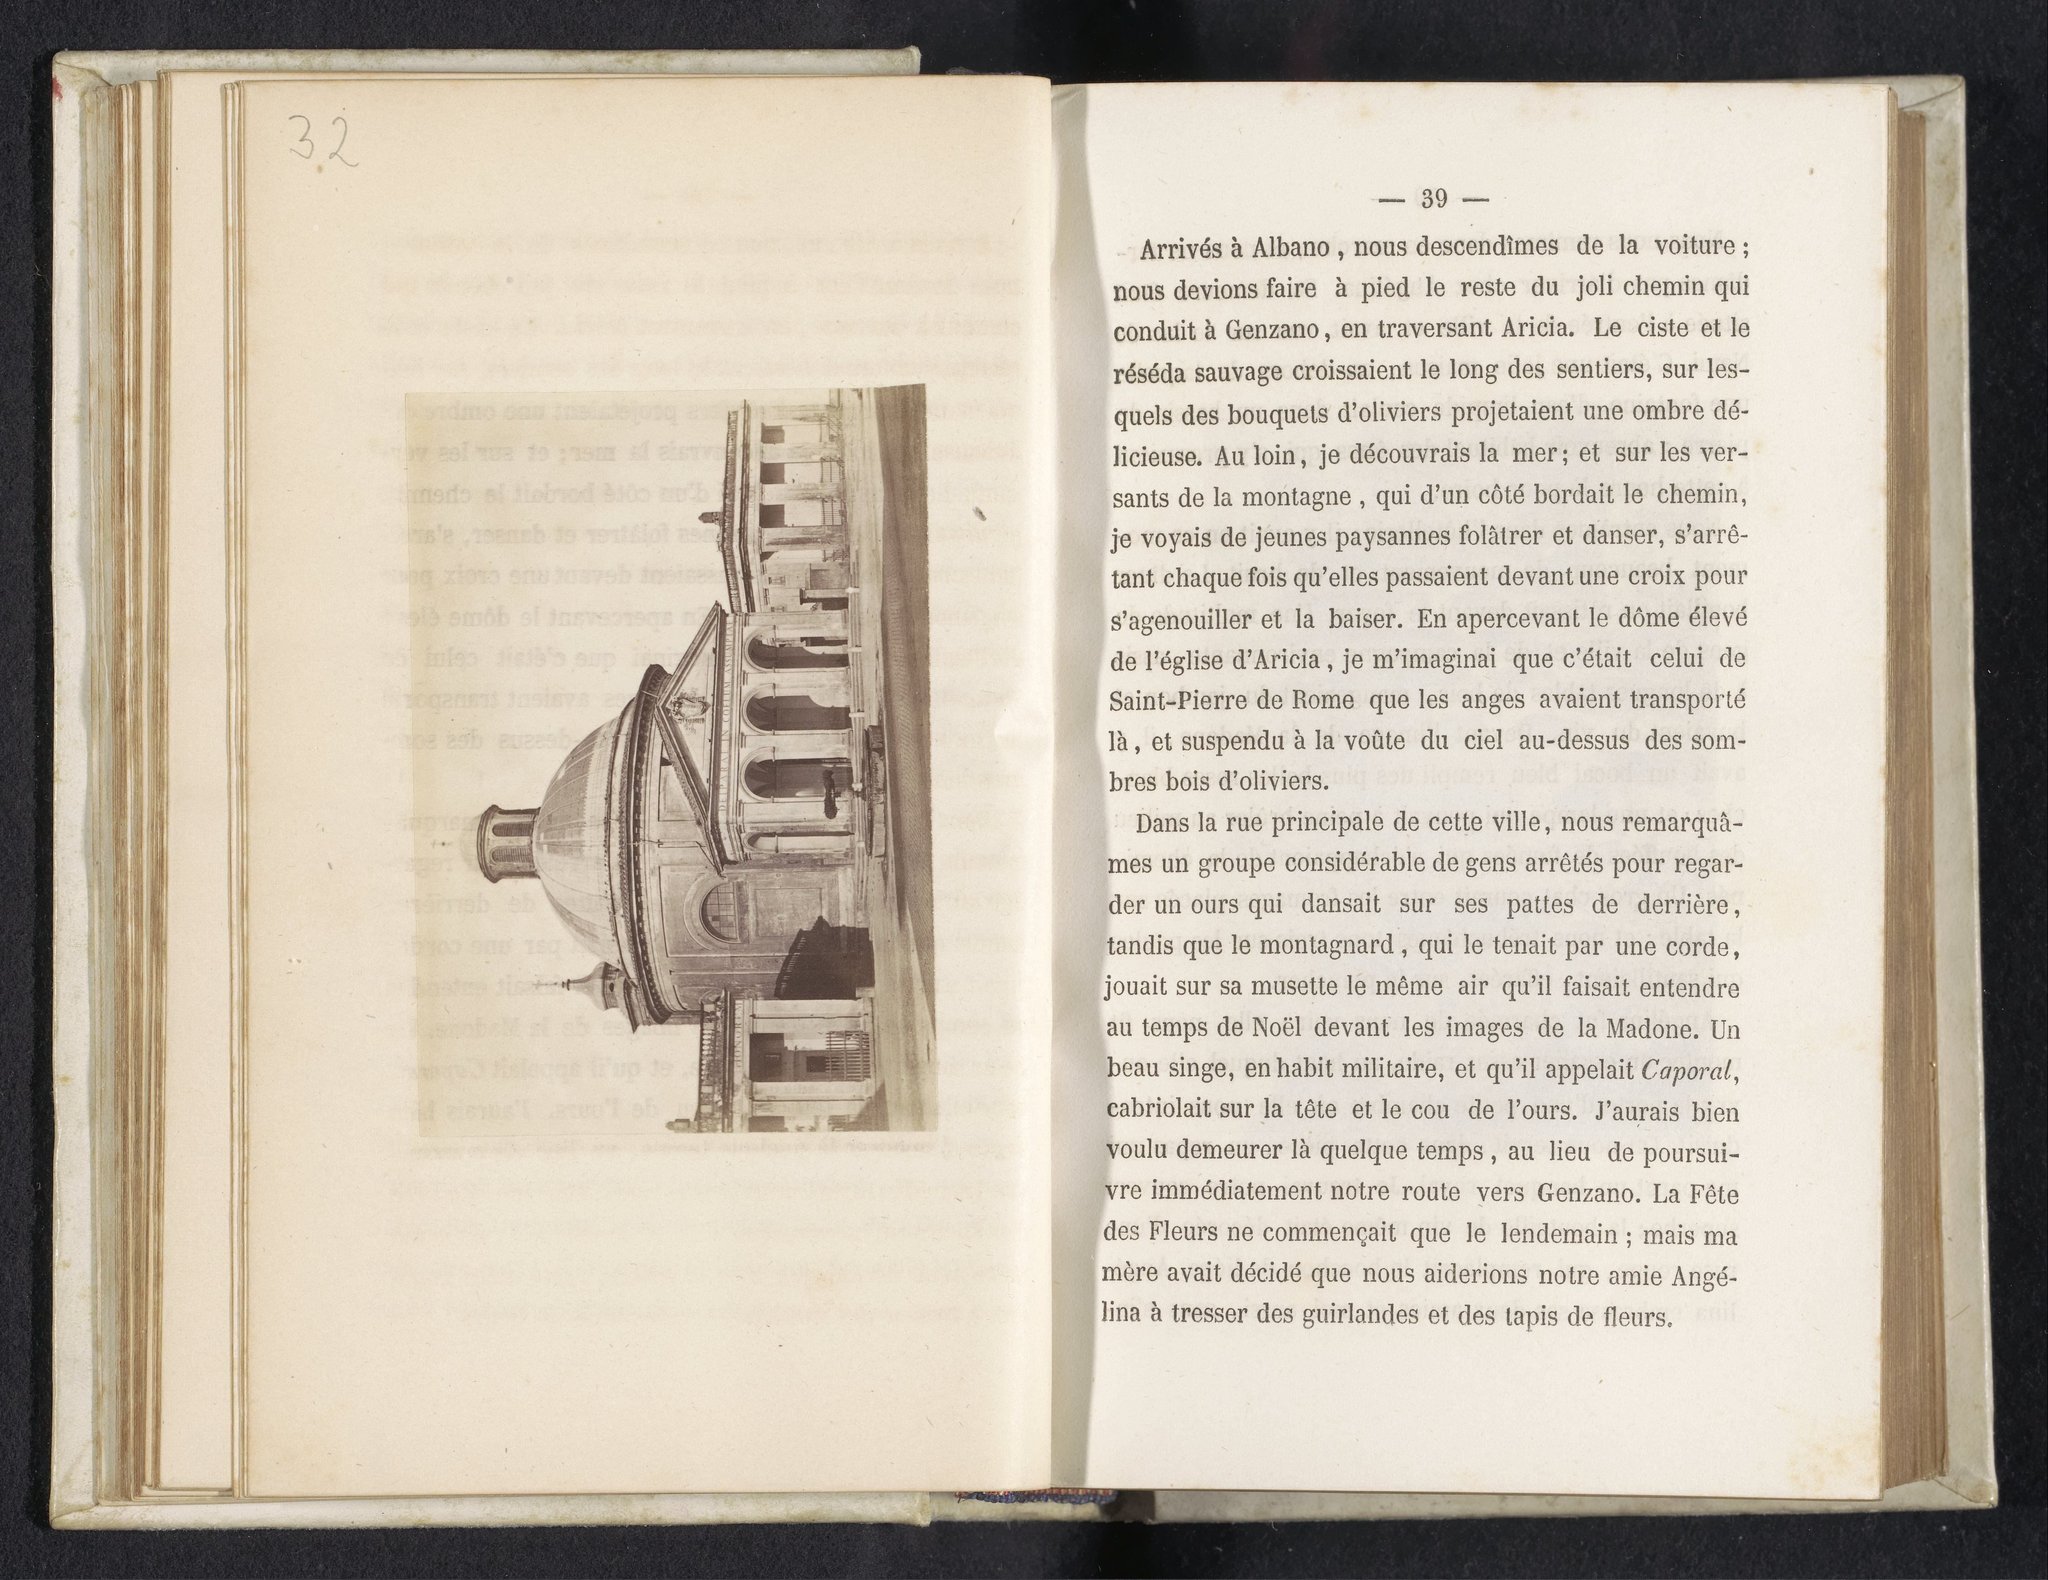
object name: photograph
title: Exterieur van de Collegiata di Santa Maria Assunta te Ariccia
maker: Anonymous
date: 1850-1860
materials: photographic support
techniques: albumen print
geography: ariccia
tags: church (exterior), façade (of house or building)